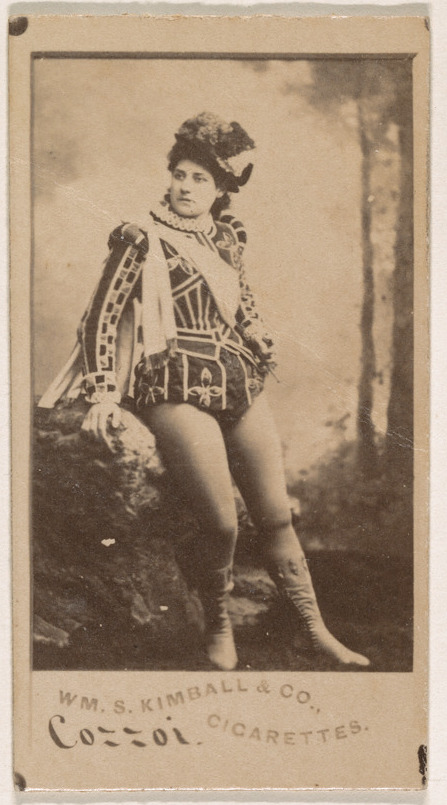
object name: photograph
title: Miss Cozzoi, from the Actresses series (N203) issued by Wm. S. Kimball & Co.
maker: william s. kimball & company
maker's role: publisher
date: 1889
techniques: color lithograph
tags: portraits,women,actresses